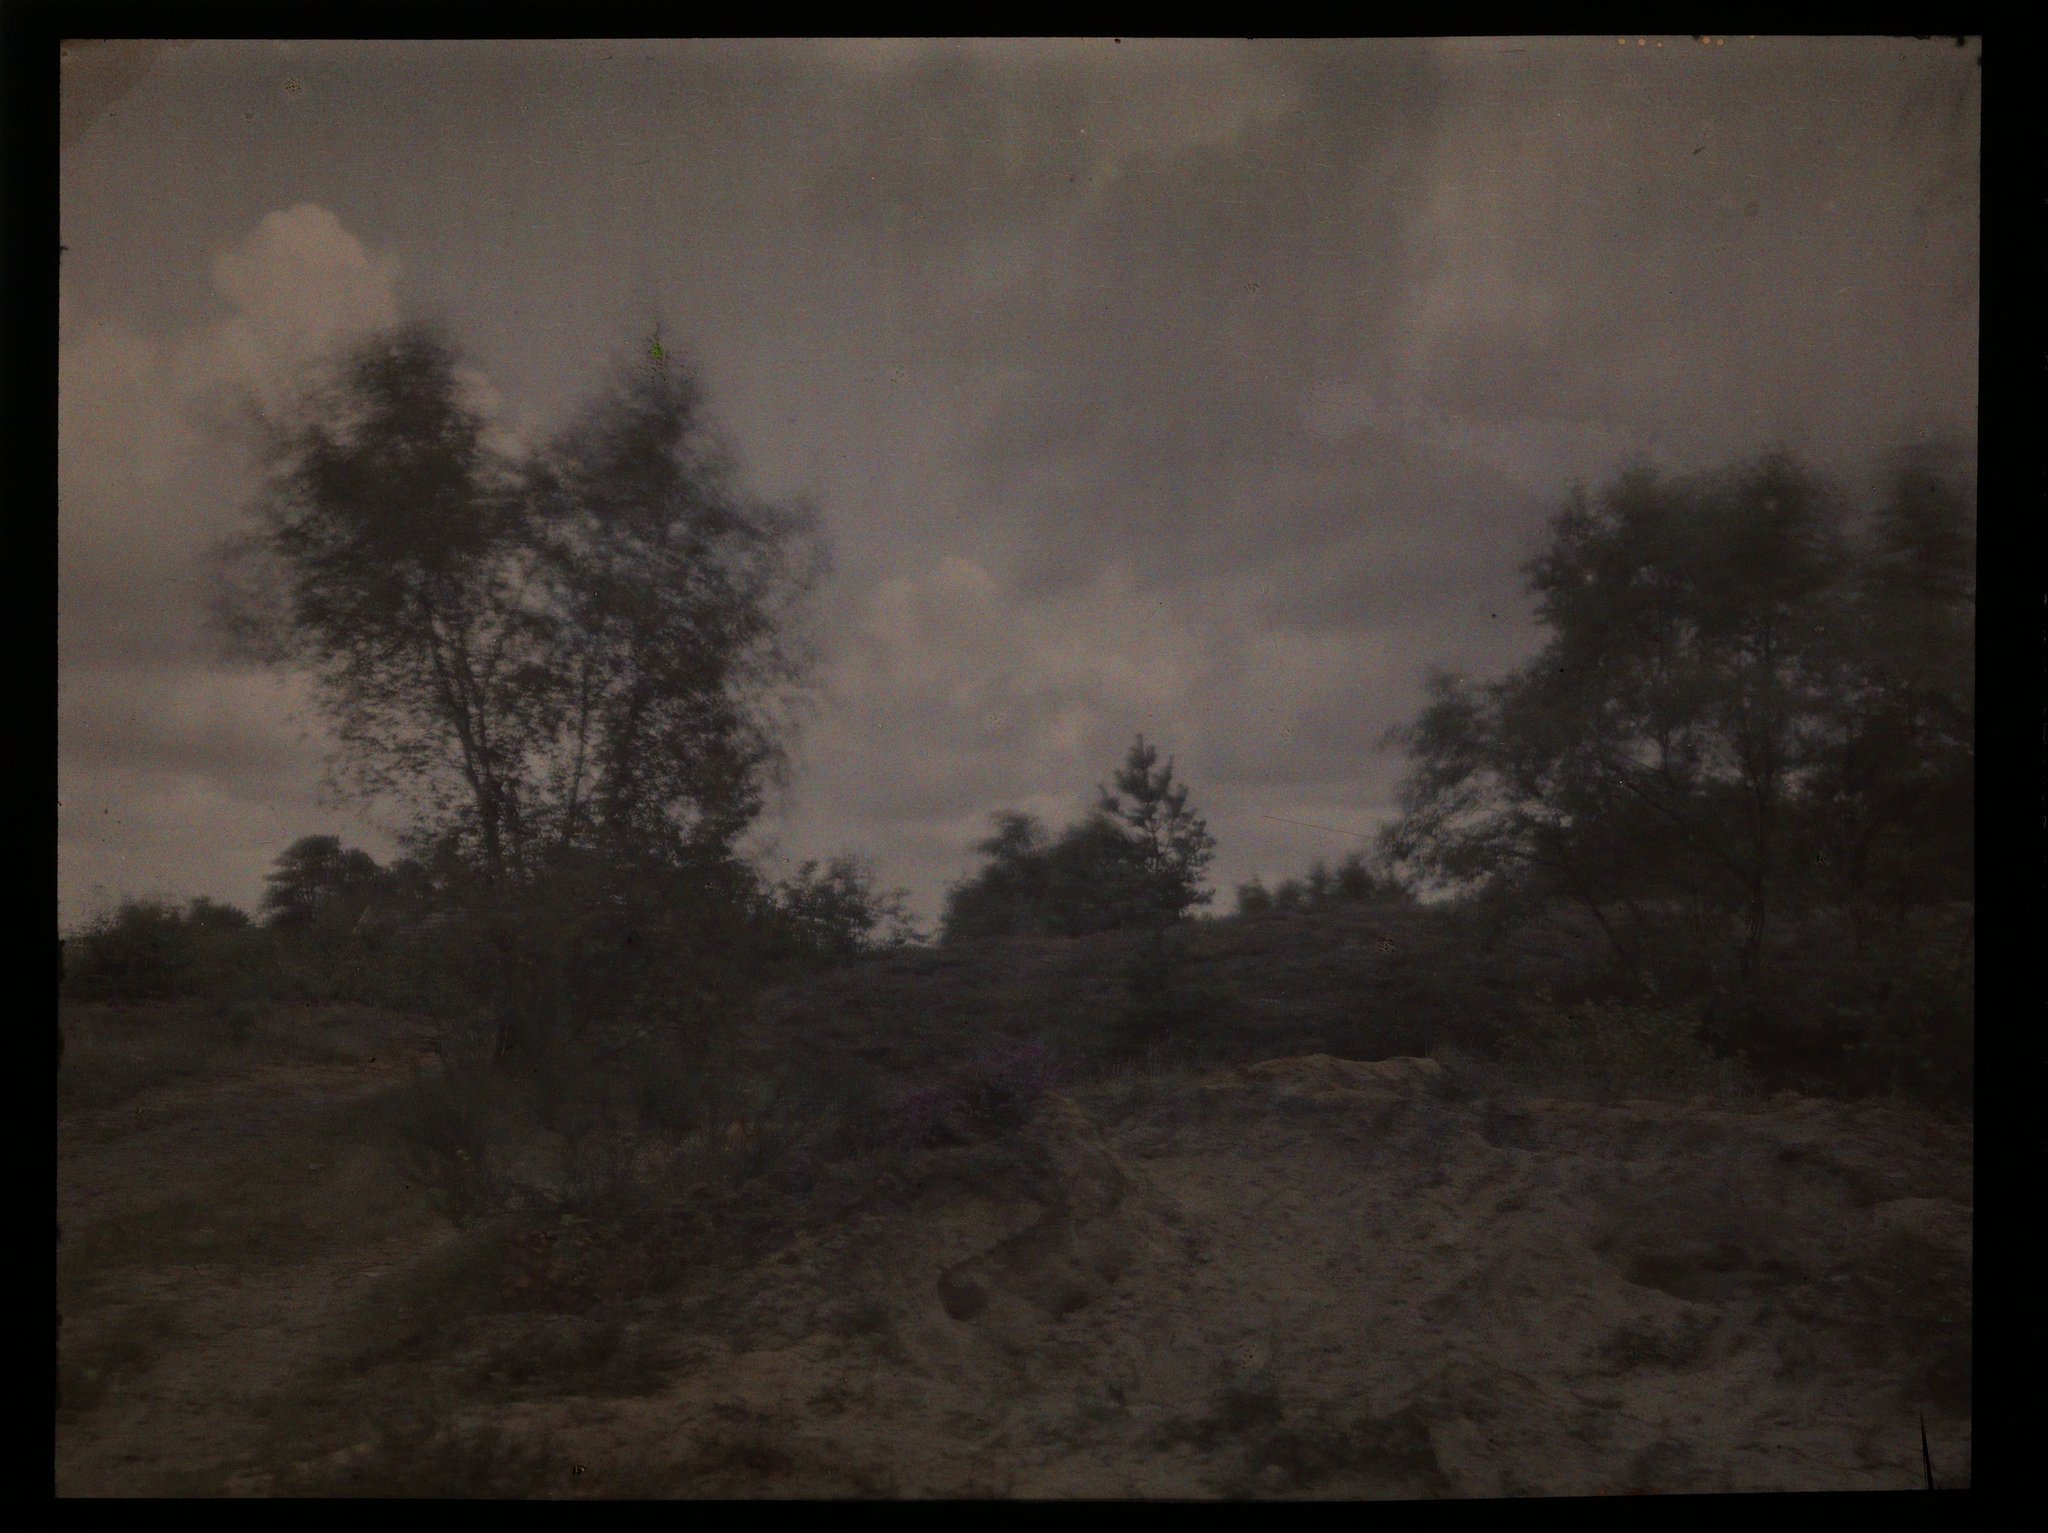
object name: photograph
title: Landschap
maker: Anonymous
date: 1907-1935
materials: glass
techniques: autochrome process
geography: netherlands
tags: dunes (sea not visible); in the dunes, netherlands